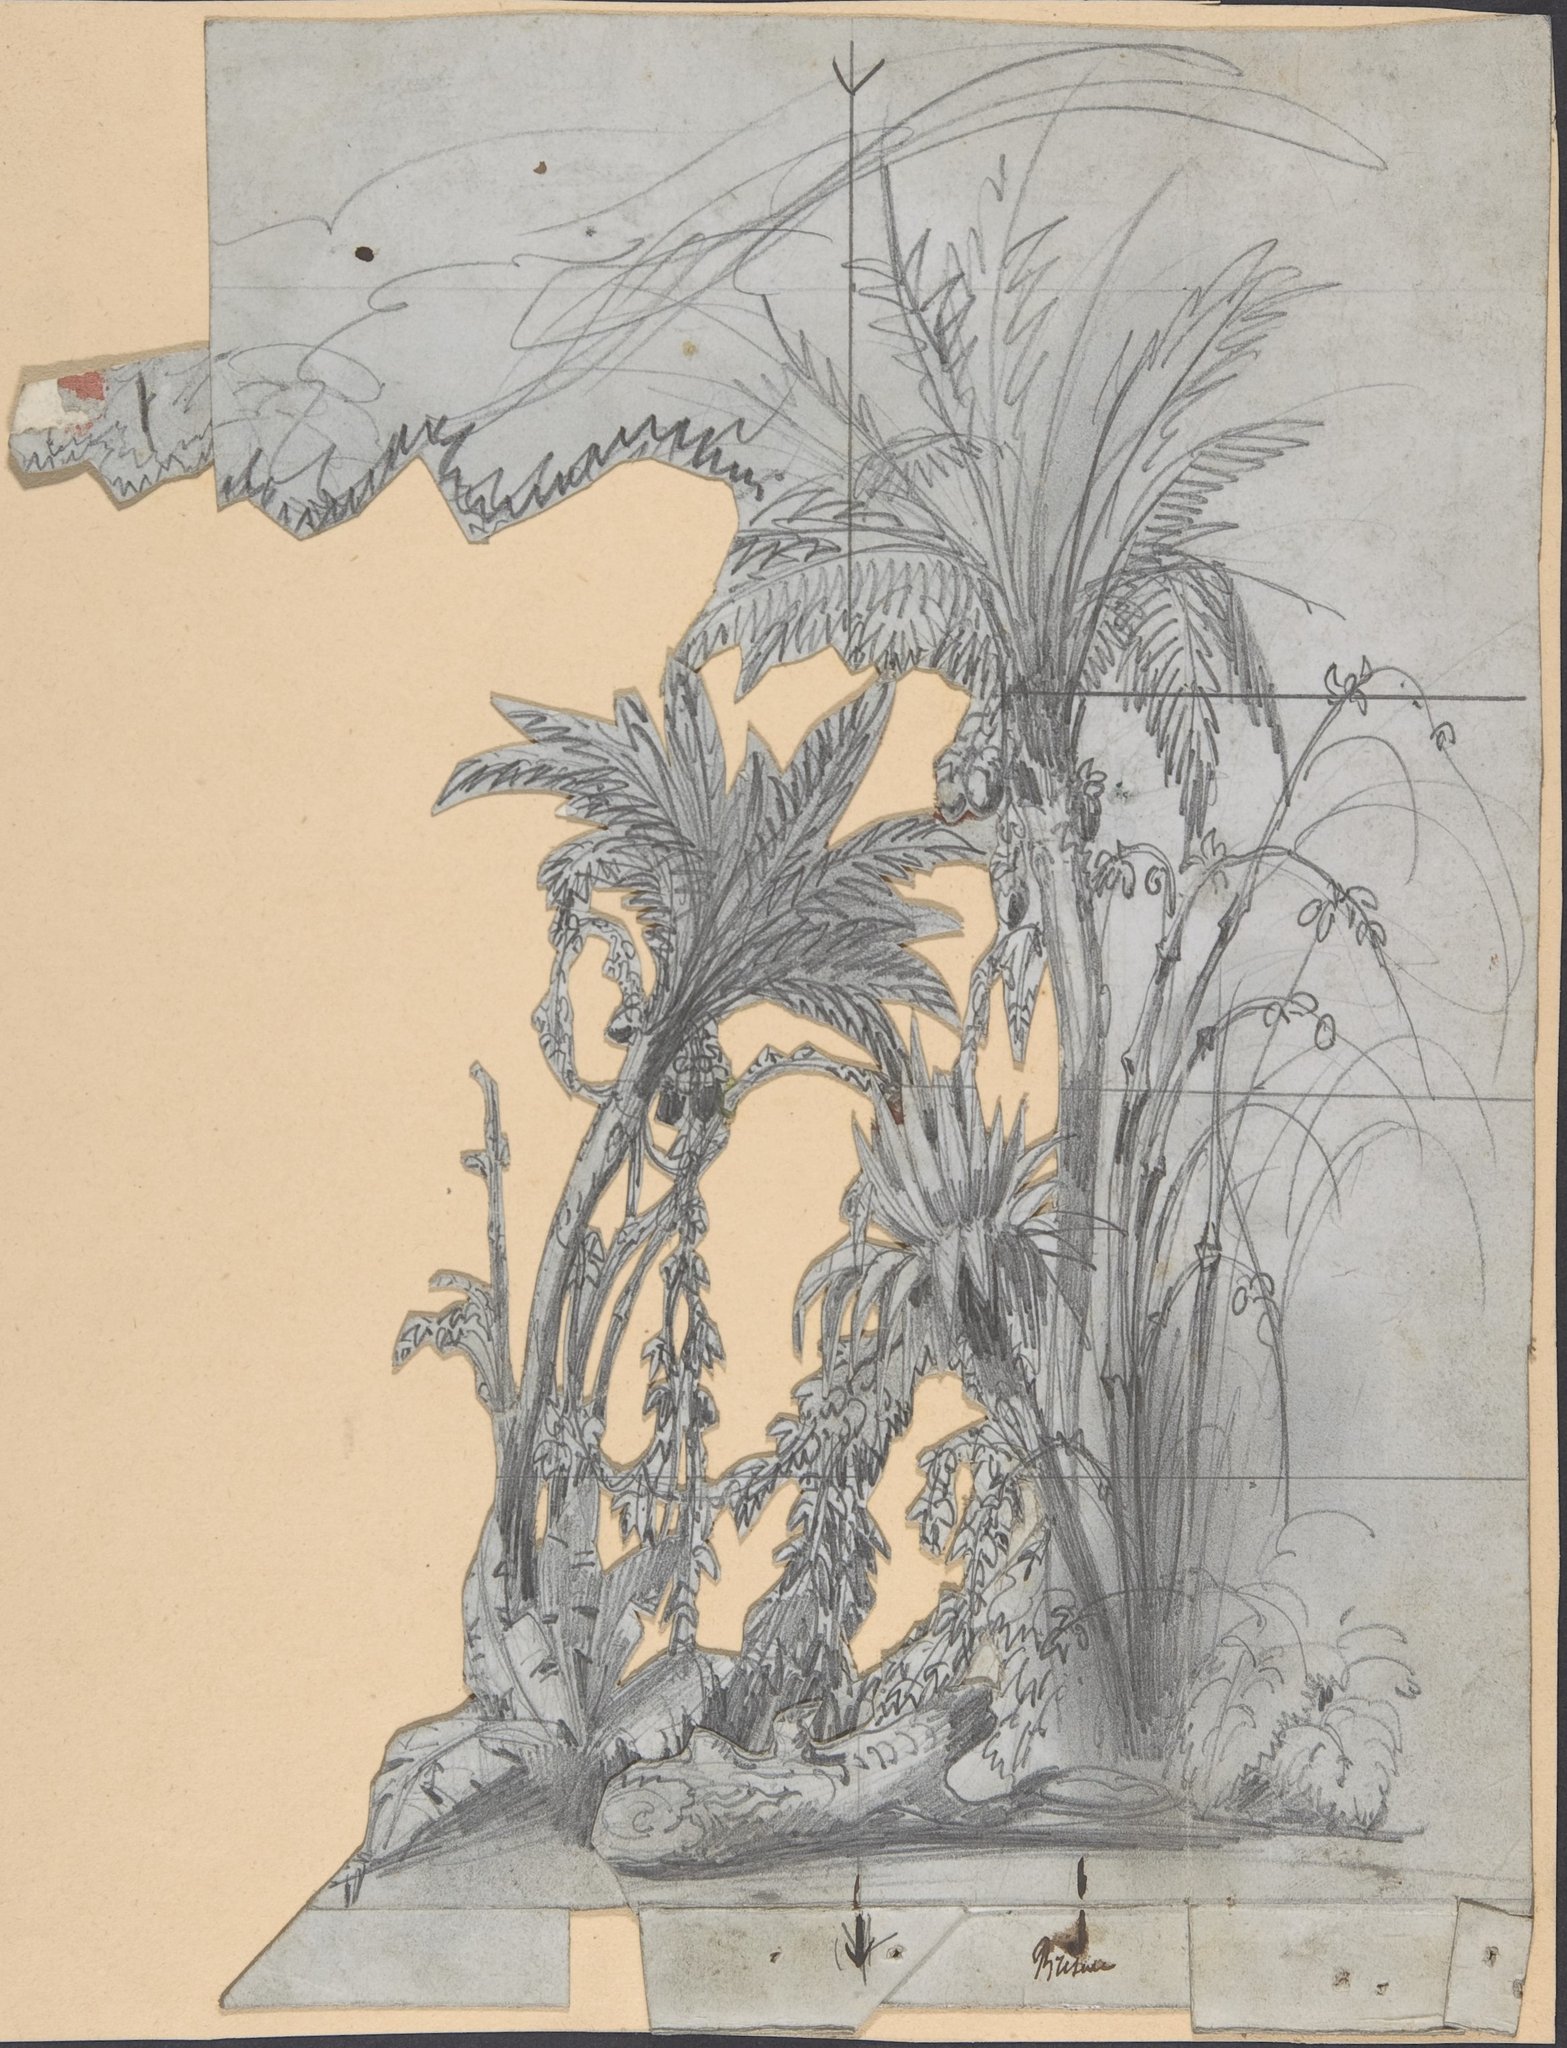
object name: drawing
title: Design for a Stage Set at the Opéra, Paris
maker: eugène cicéri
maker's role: artist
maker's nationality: french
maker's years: 1813-1890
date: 1830-1890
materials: graphite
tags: plants,stage design